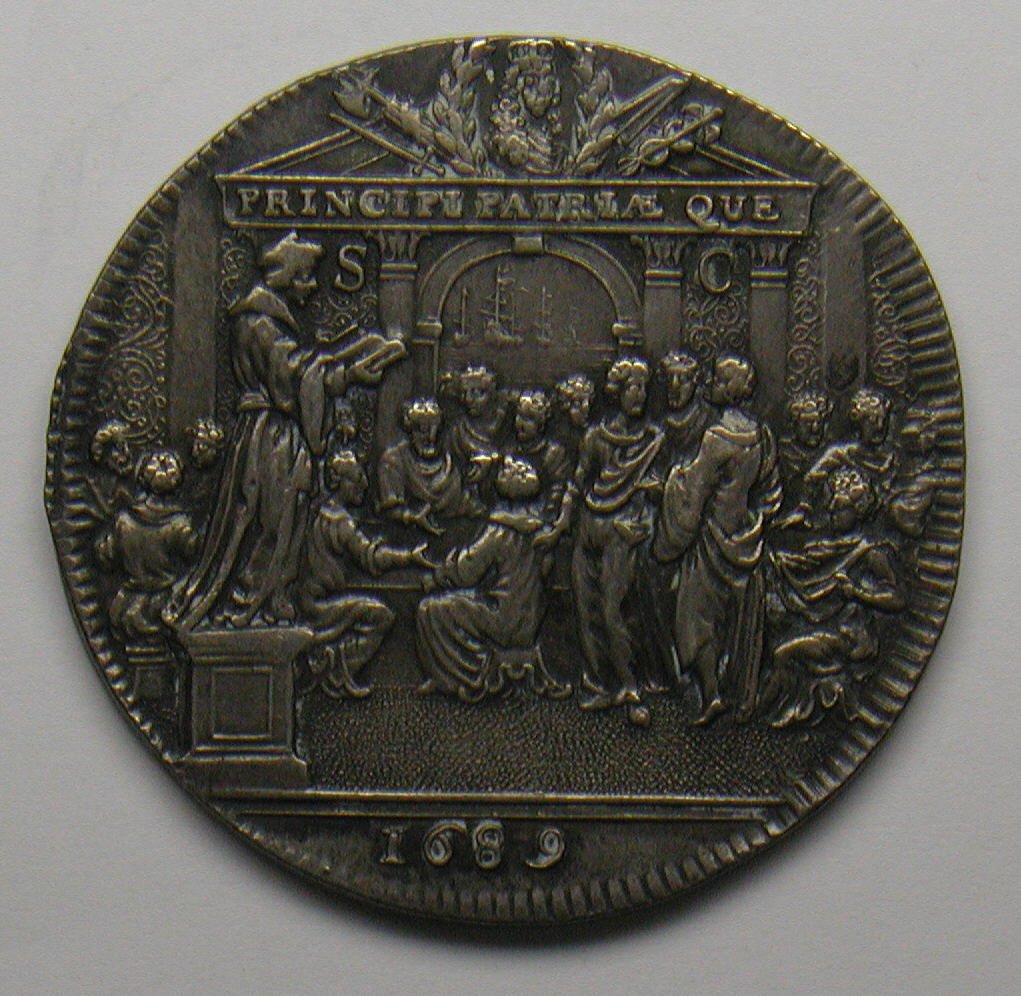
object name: jeton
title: Rotterdam's celebration of the coronation of William of Orange as King of England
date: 1689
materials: silver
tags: men